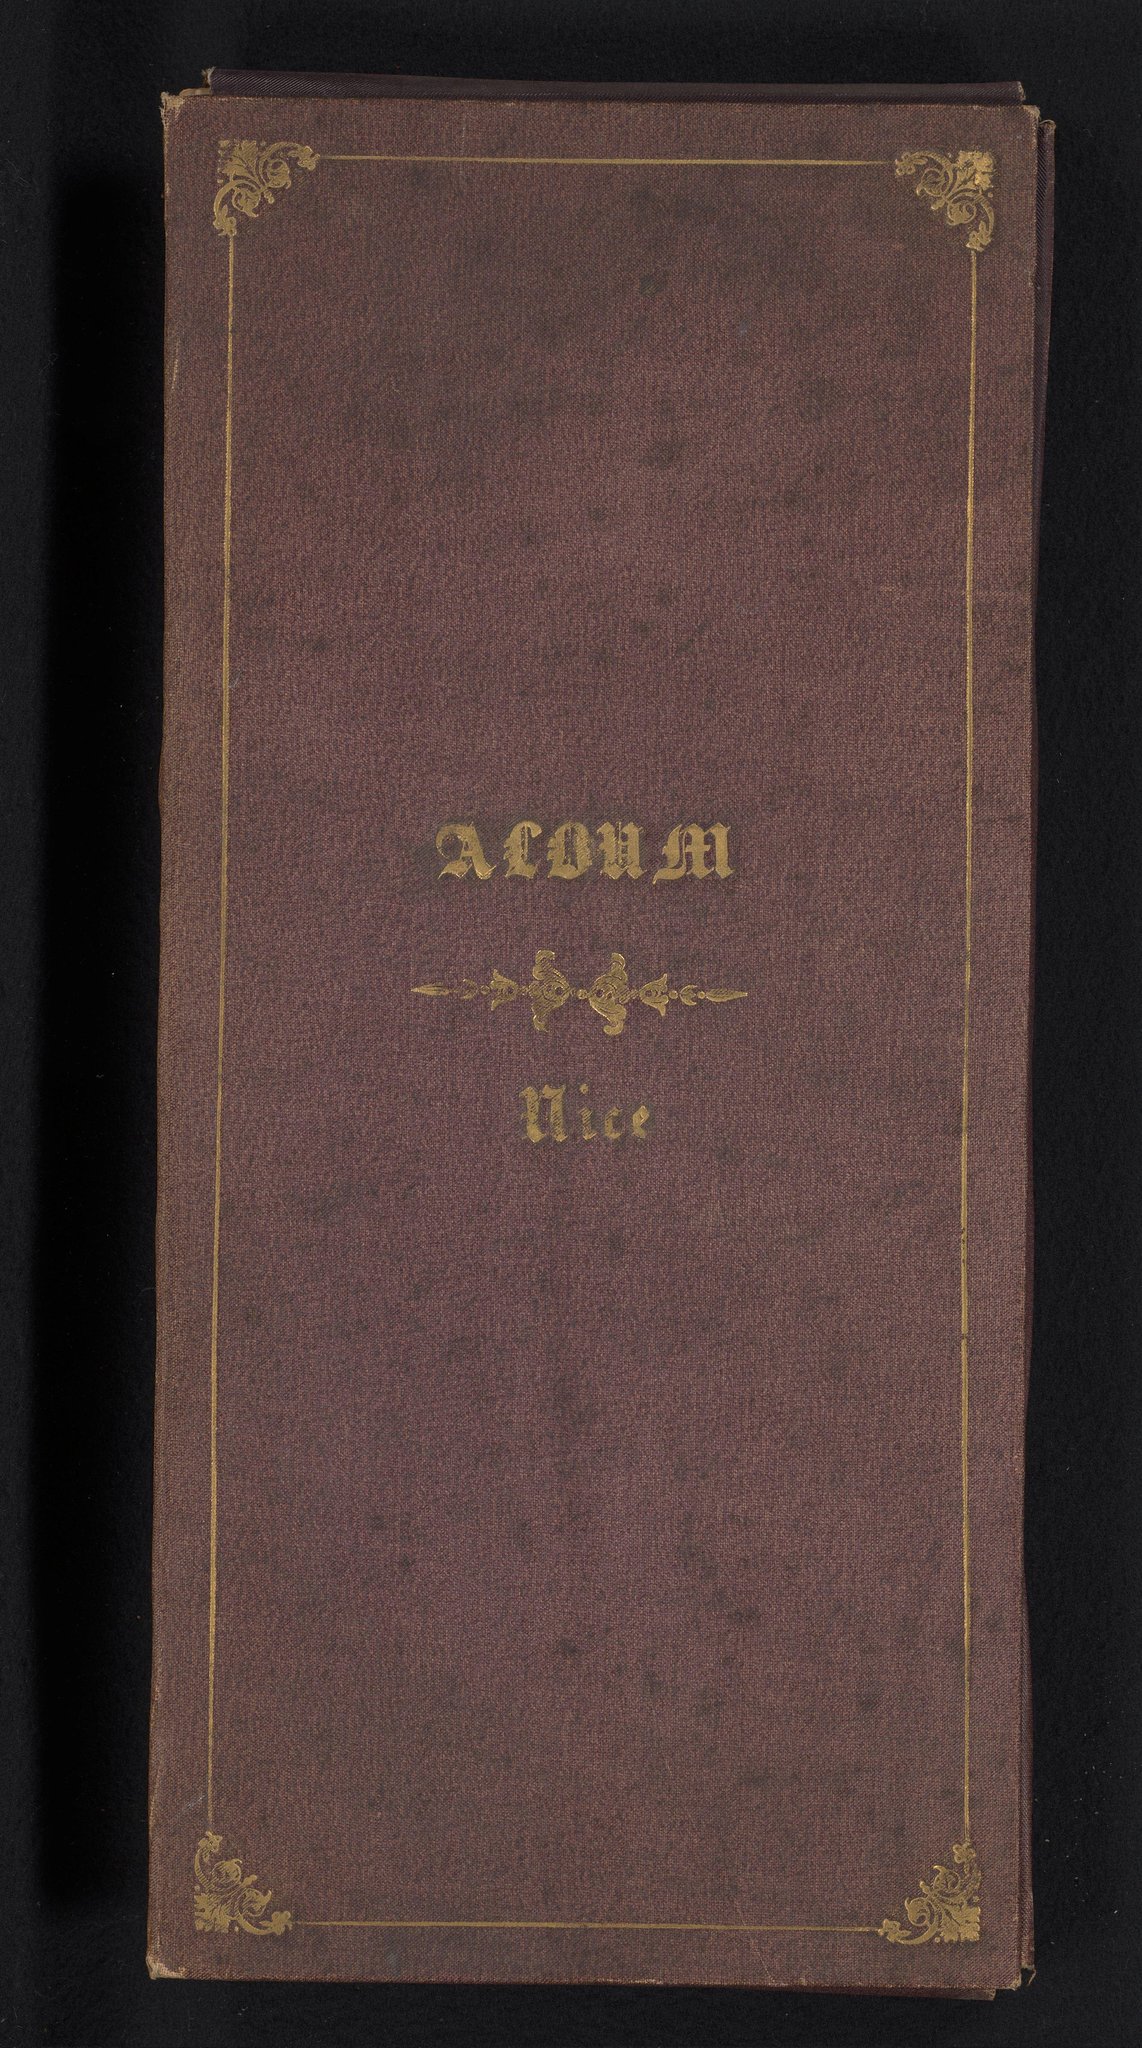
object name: folder container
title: Map met 14 foto's van Nice, Côte d'Azur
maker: eugène degand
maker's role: painter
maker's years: 1829-1911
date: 1872-1874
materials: cardboard, textile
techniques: printing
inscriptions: annotation: ‘25,-’, inscription: ‘Dienst/ Verspreide/ Rijkskollekties (...)’